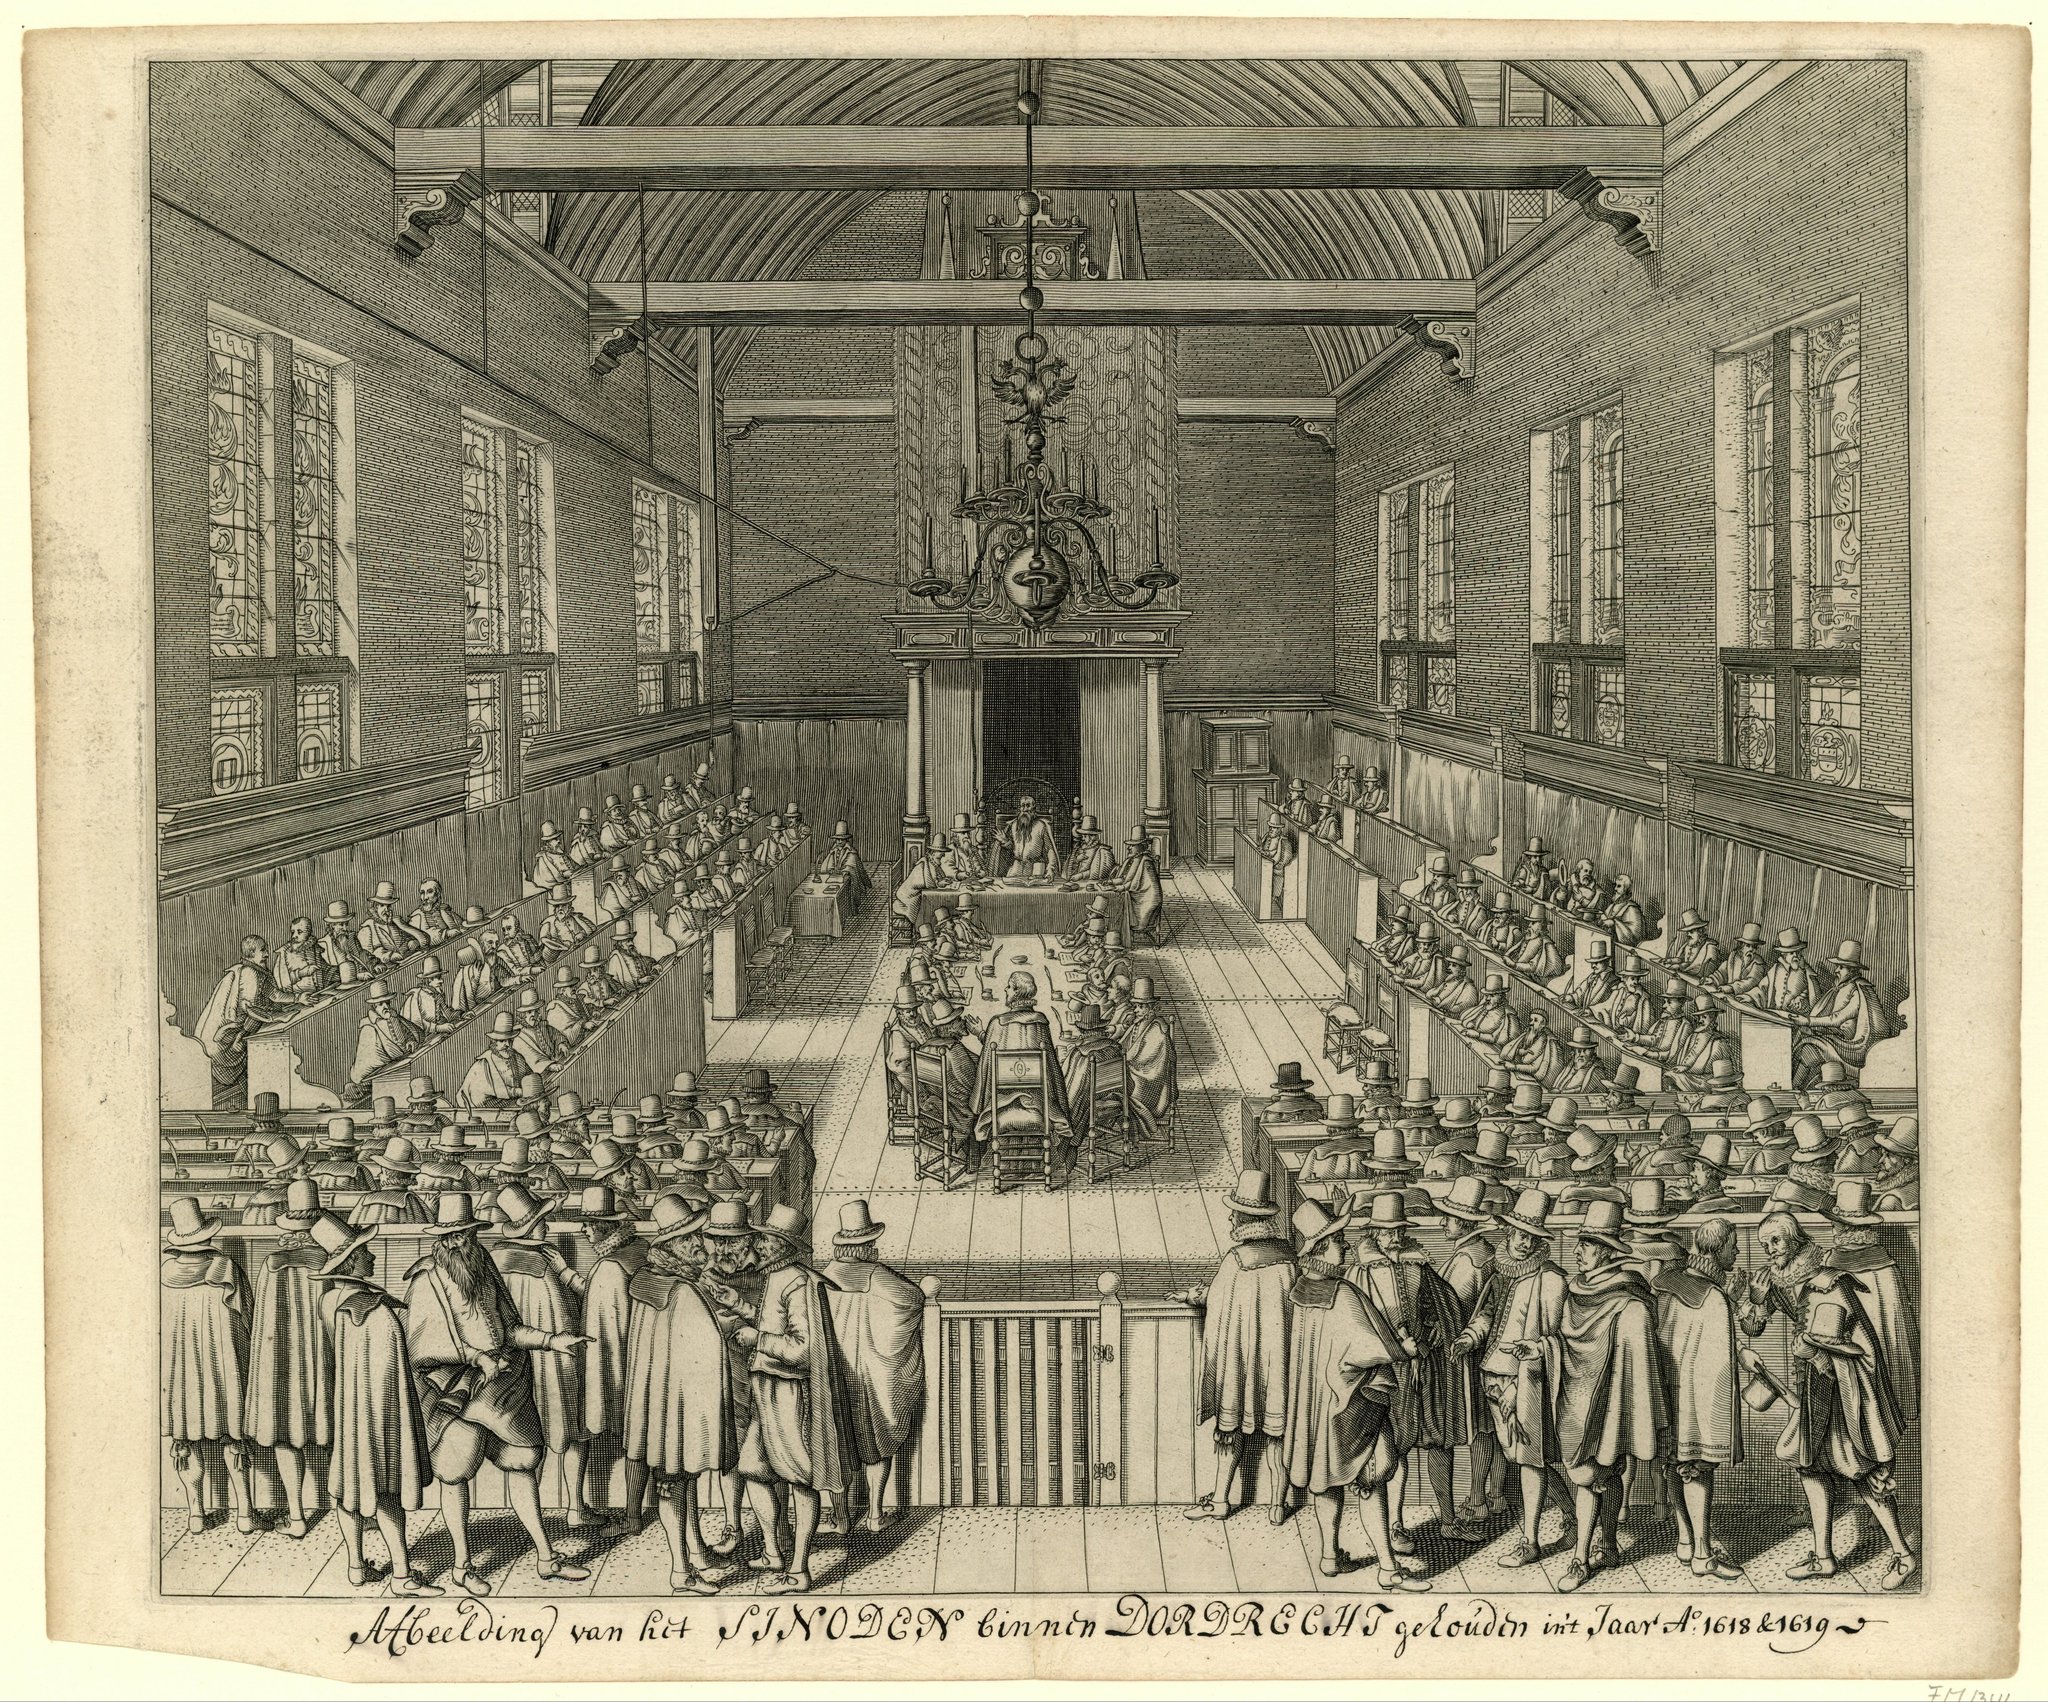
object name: print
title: De opening van de nationale synode te Dordrecht, 1618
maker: Anonymous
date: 1618-1619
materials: paper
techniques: engraving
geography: northern netherlands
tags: organizations, assemblies, etc. in protestant churches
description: De opening van de nationale synode te Dordrecht op 13 november 1618. De voorstelling geeft een overzicht van de grote zaal met alle aanwezigen en toeschouwers. De prent bevat geen opschriften of inscripties. Onder de voorstelling is met de de hand de titel geschreven.